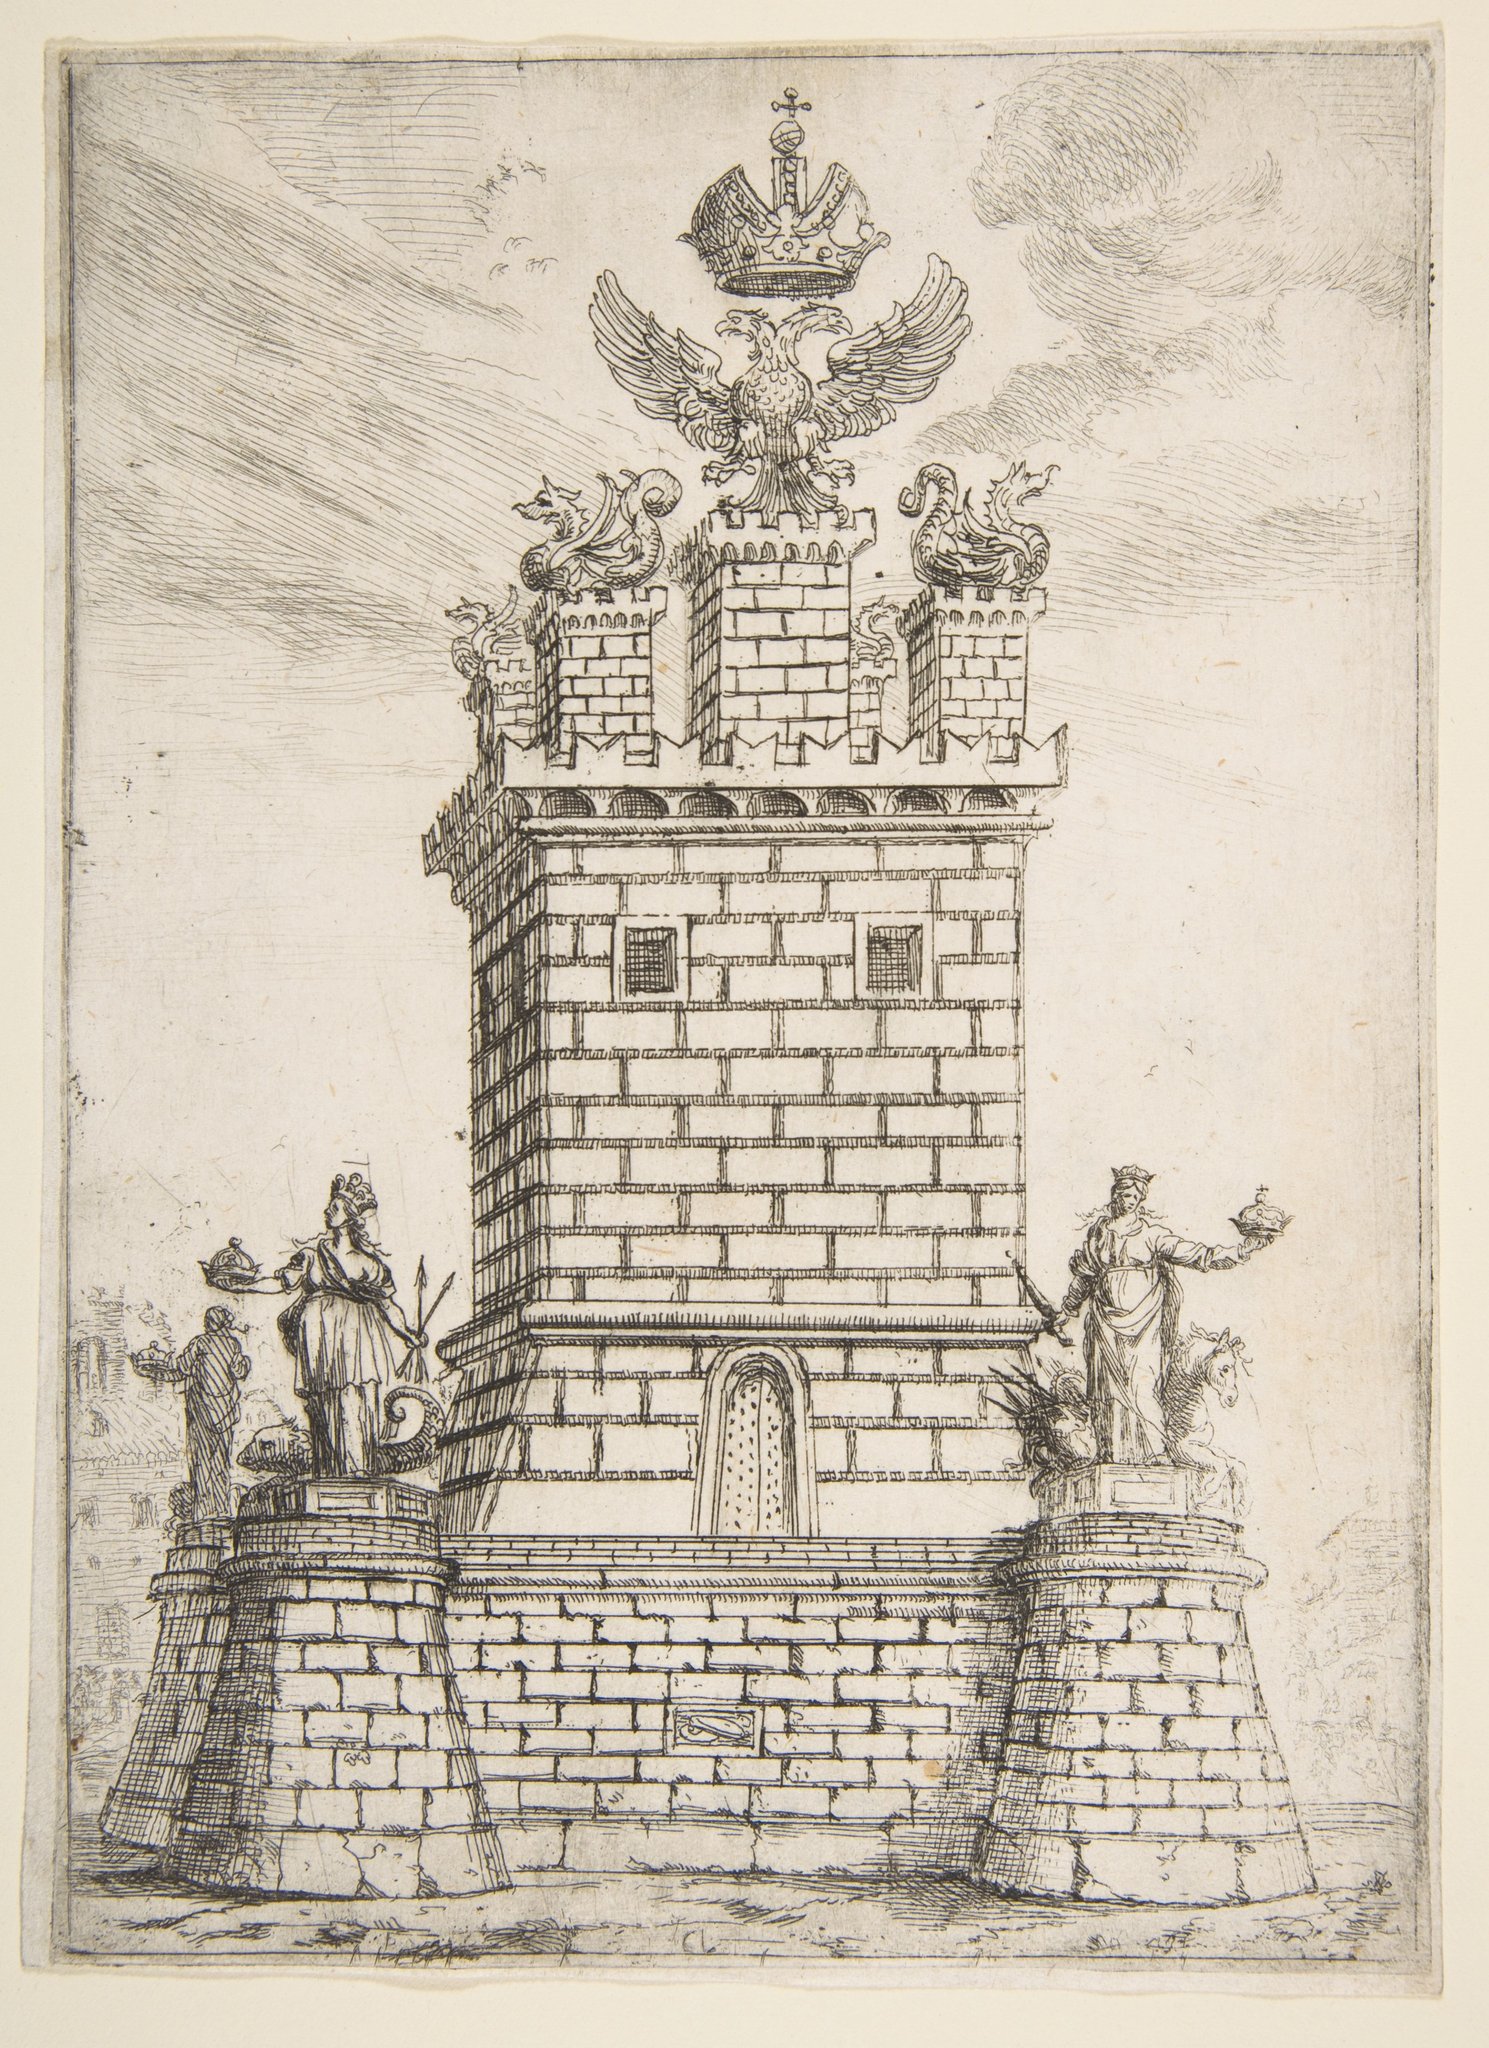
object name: print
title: The Square Tower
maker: claude lorrain (claude gellée)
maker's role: artist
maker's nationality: french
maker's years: 1604-1682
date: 1637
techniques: etching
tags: birds,sculpture,towers,men,women